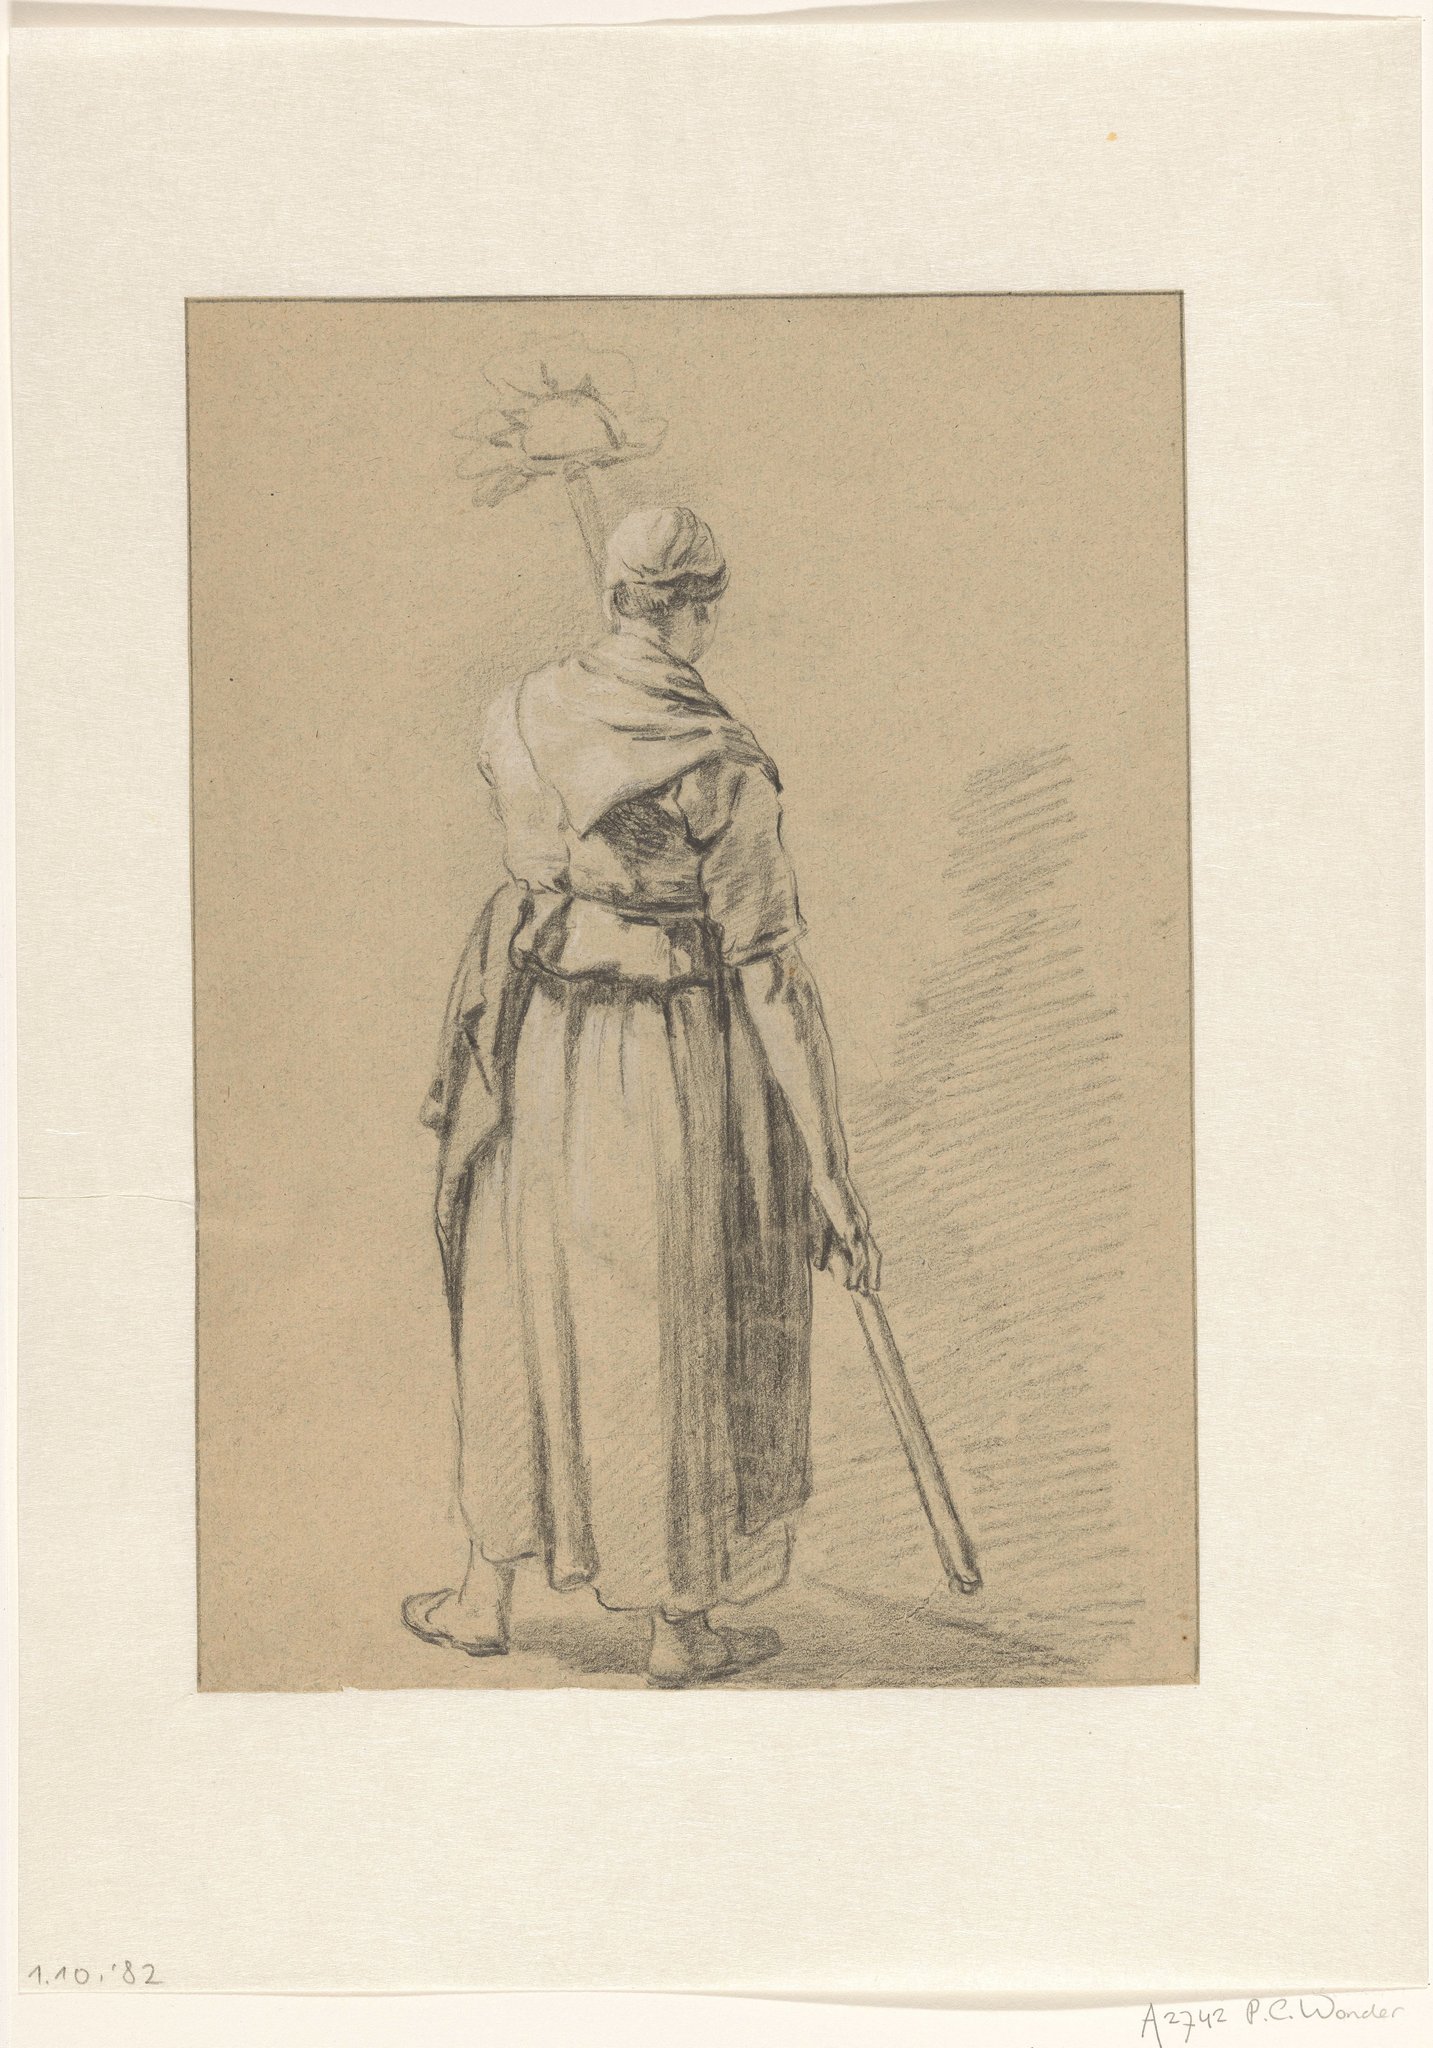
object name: drawing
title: Staande vrouw op de rug gezien, met ragebol in de handen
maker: pieter christoffel wonder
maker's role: draughtsman, painter, print maker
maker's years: 1780-1852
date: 1790-1852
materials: chalk, paper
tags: sitting figure - aa - female human figure, cleaning (the house)